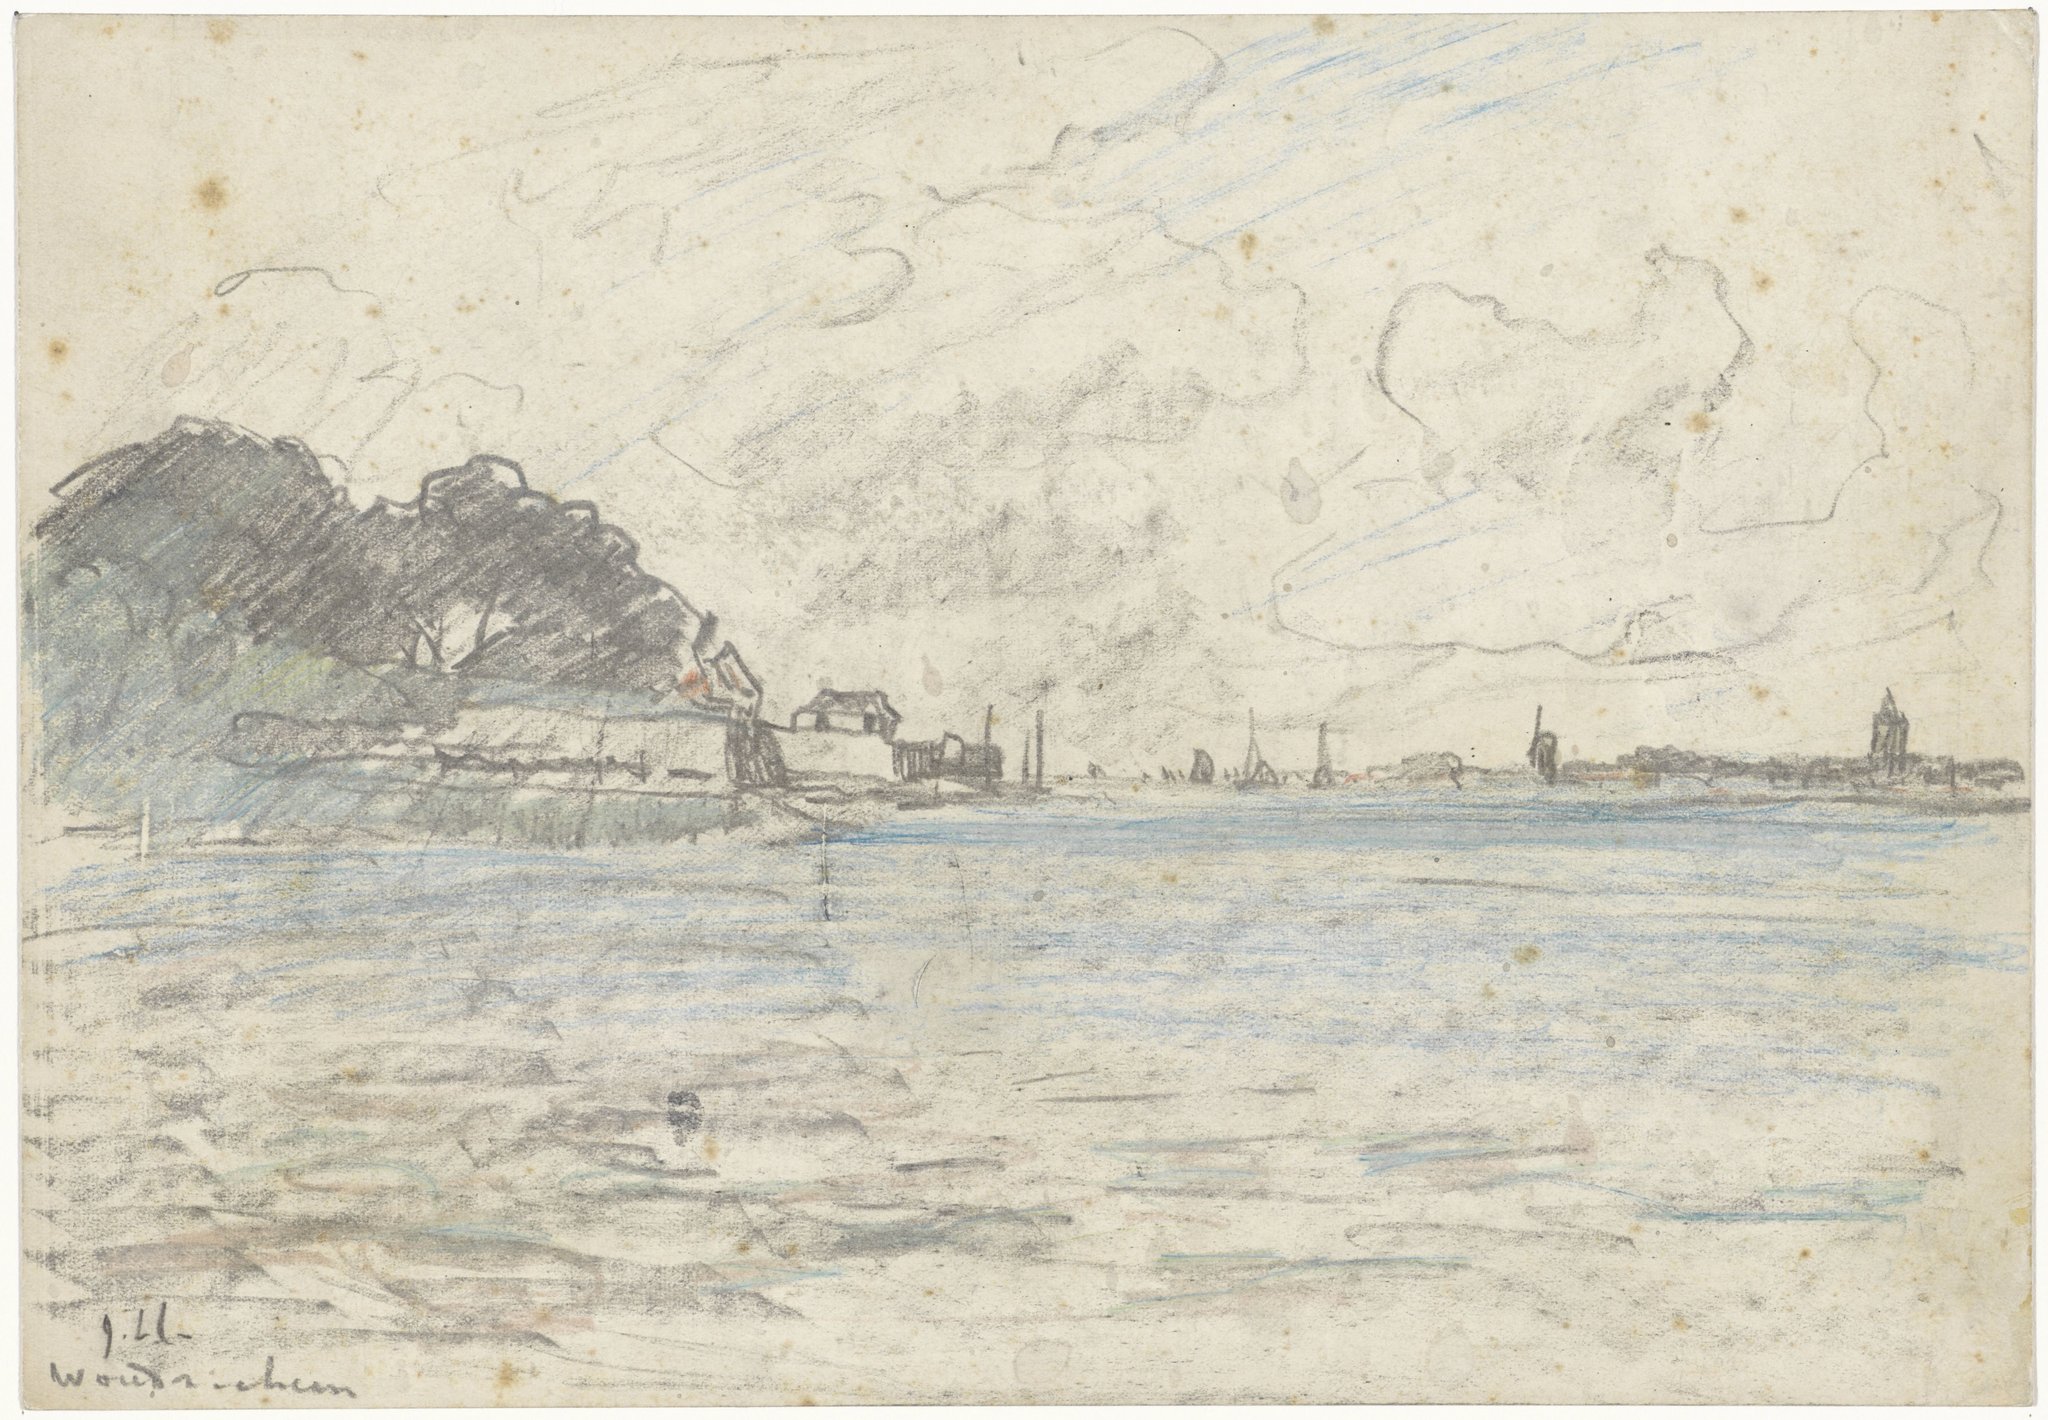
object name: drawing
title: Gezicht over het water op Woudrichem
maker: adolf le comte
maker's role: draughtsman, painter, print maker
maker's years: 1850-1921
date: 1860-1921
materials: chalk, paper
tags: river, prospect of city, town panorama, silhouette of city, woudrichem